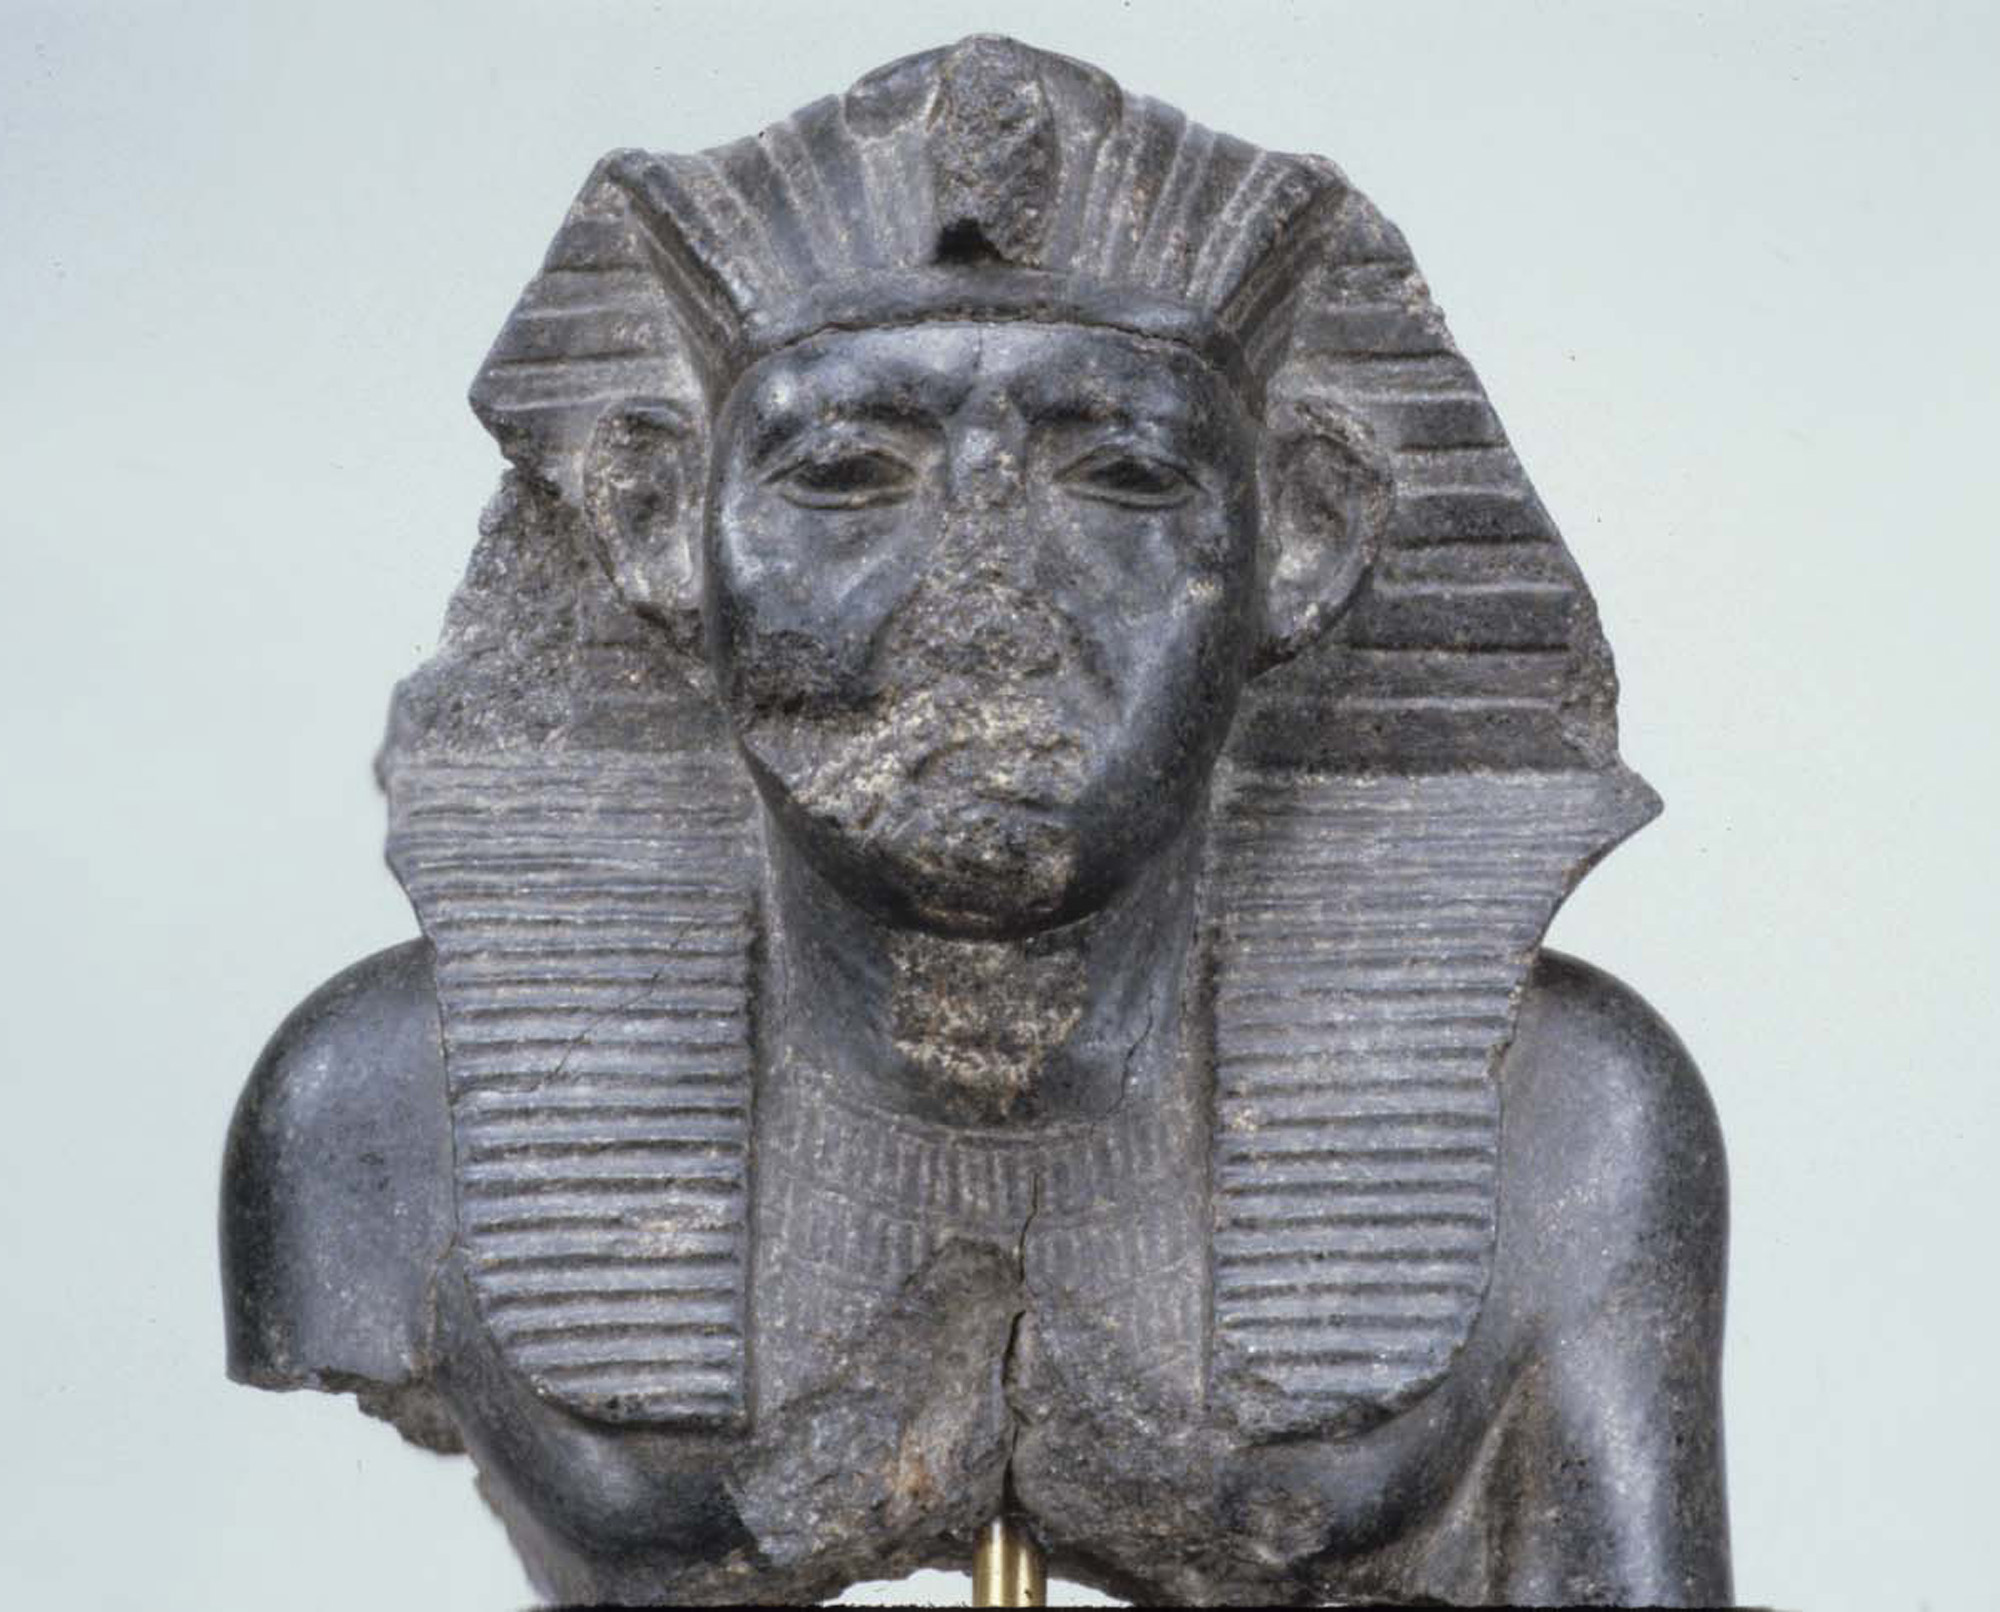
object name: bust, amenemhat iii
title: Bust of King Amenemhat III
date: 1859-1813 BCE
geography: egypt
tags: kings,mk-kings